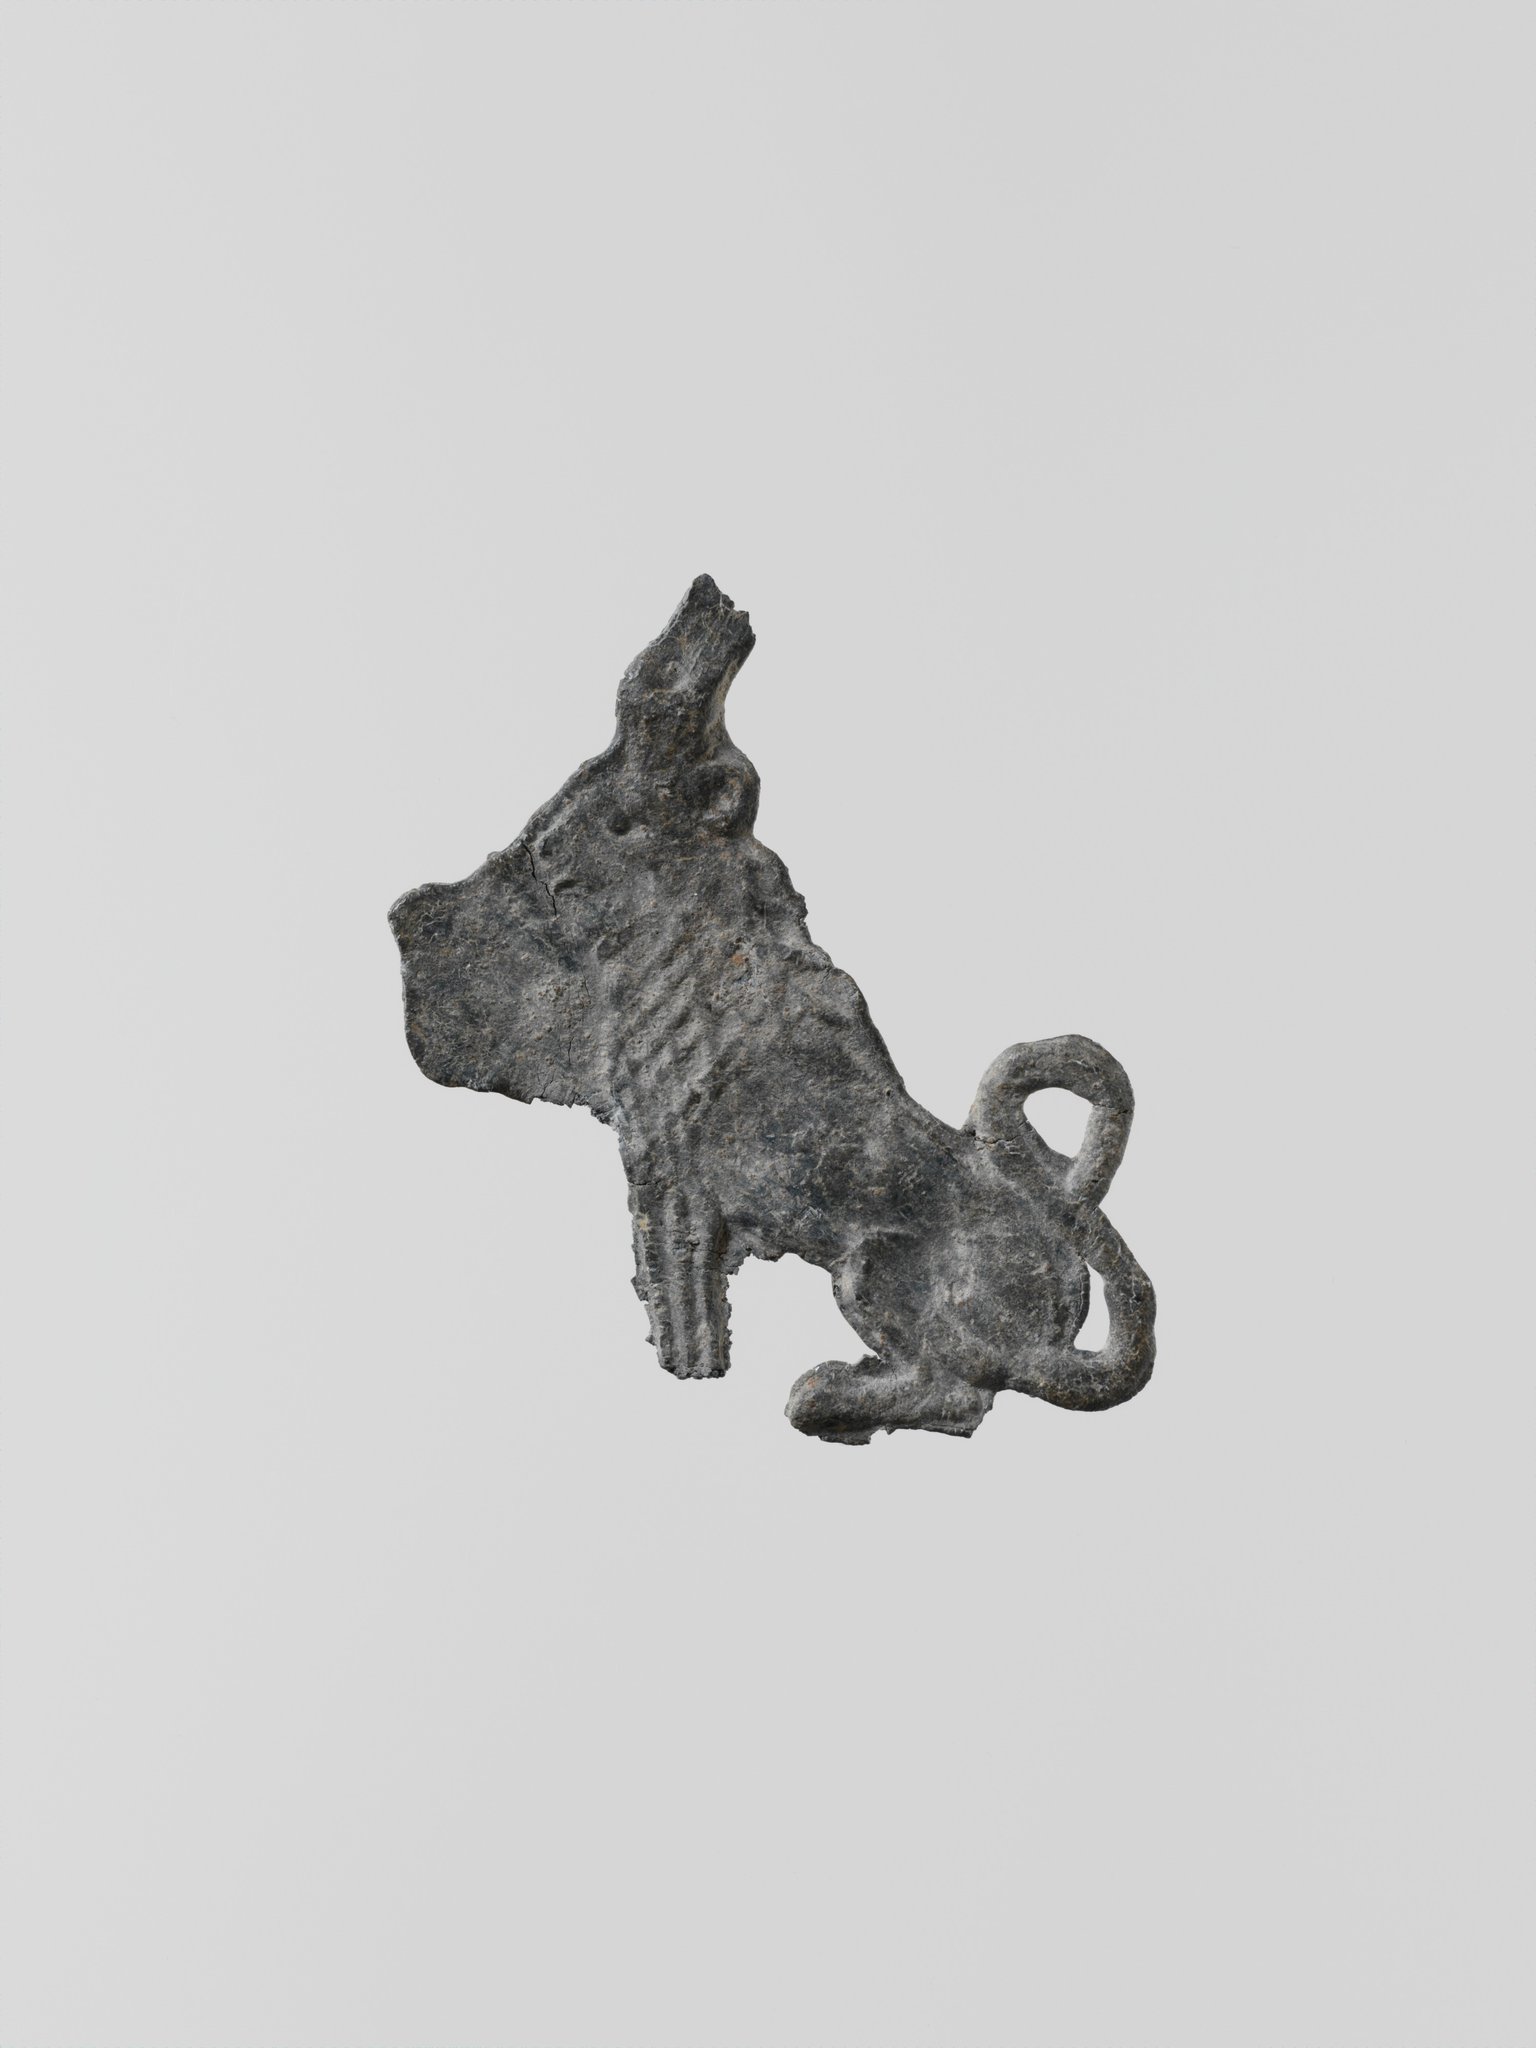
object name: statuette of a lion, 3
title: Lead figure of a lion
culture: greek, laconian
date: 600-401 BCE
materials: lead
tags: lions